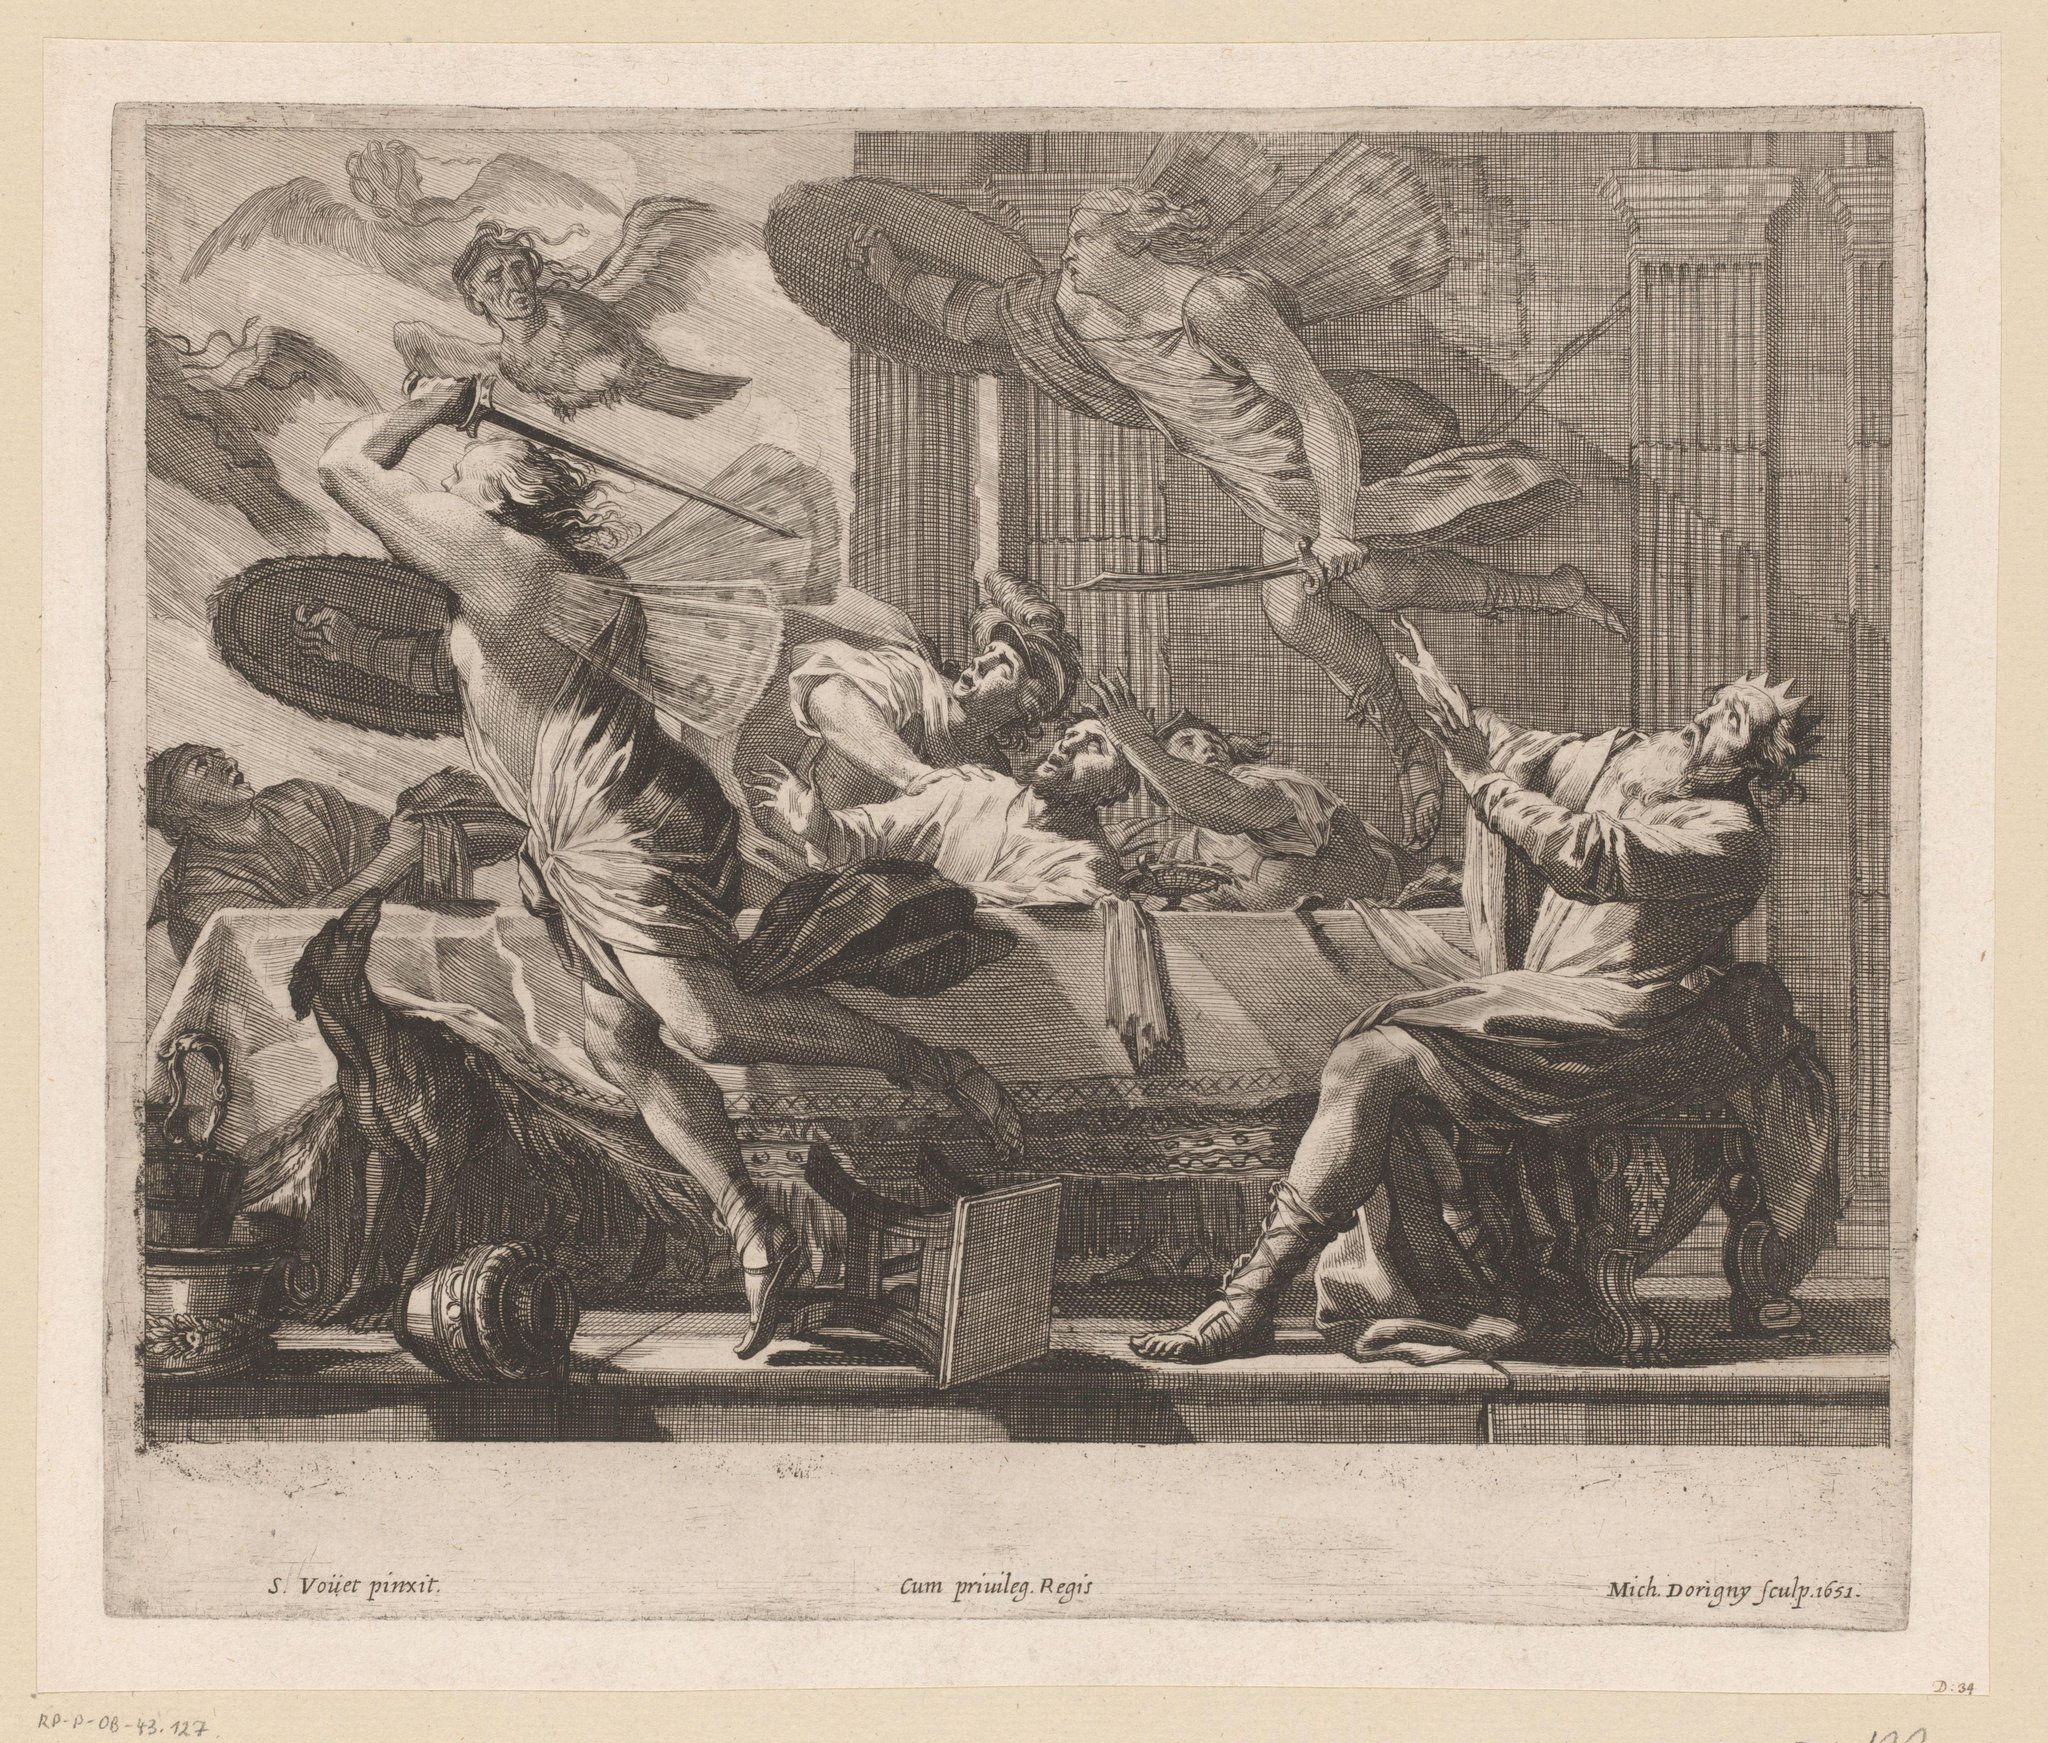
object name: print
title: Phineus en zijn volgelingen in steen veranderd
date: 1651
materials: paper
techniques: engraving, etching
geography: france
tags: phineus and his attendants are turned into stone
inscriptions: collector's mark: Lugt 240